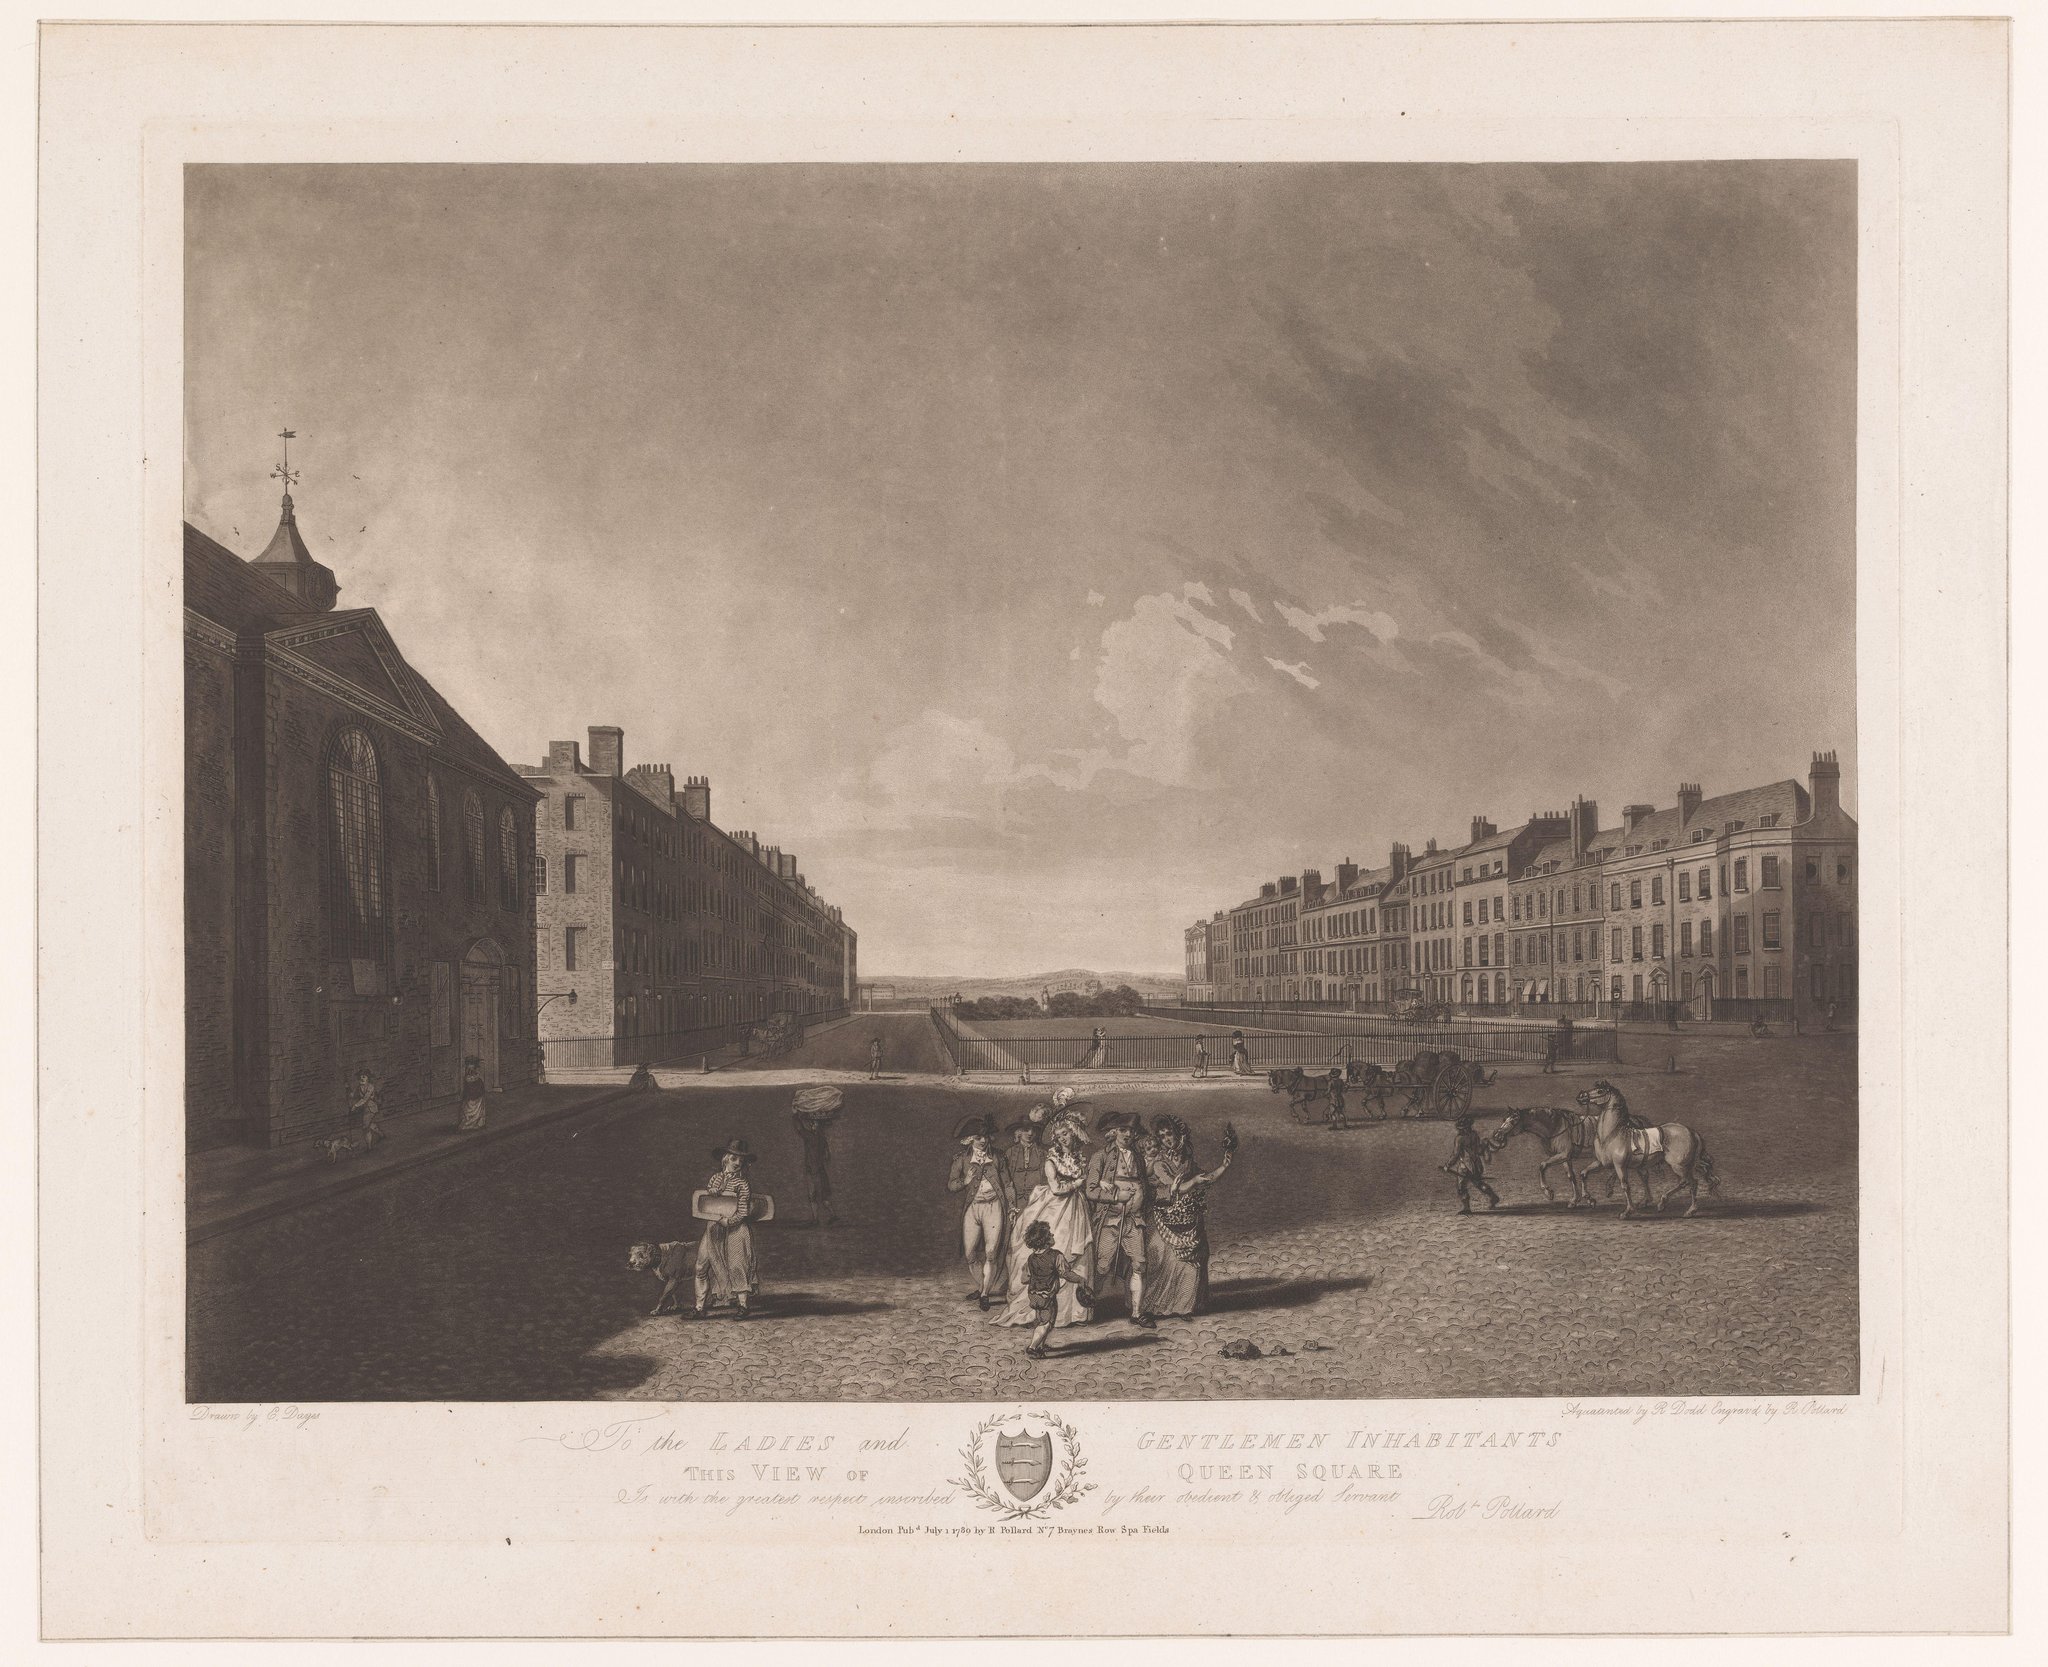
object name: print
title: Gezicht op Queen Square te Londen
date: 1707-1789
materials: paper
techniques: aquatint, etching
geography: london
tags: square, place, circus, etc. (+ city(-scape) with figures, staffage)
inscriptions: collector's mark: Lugt 2233